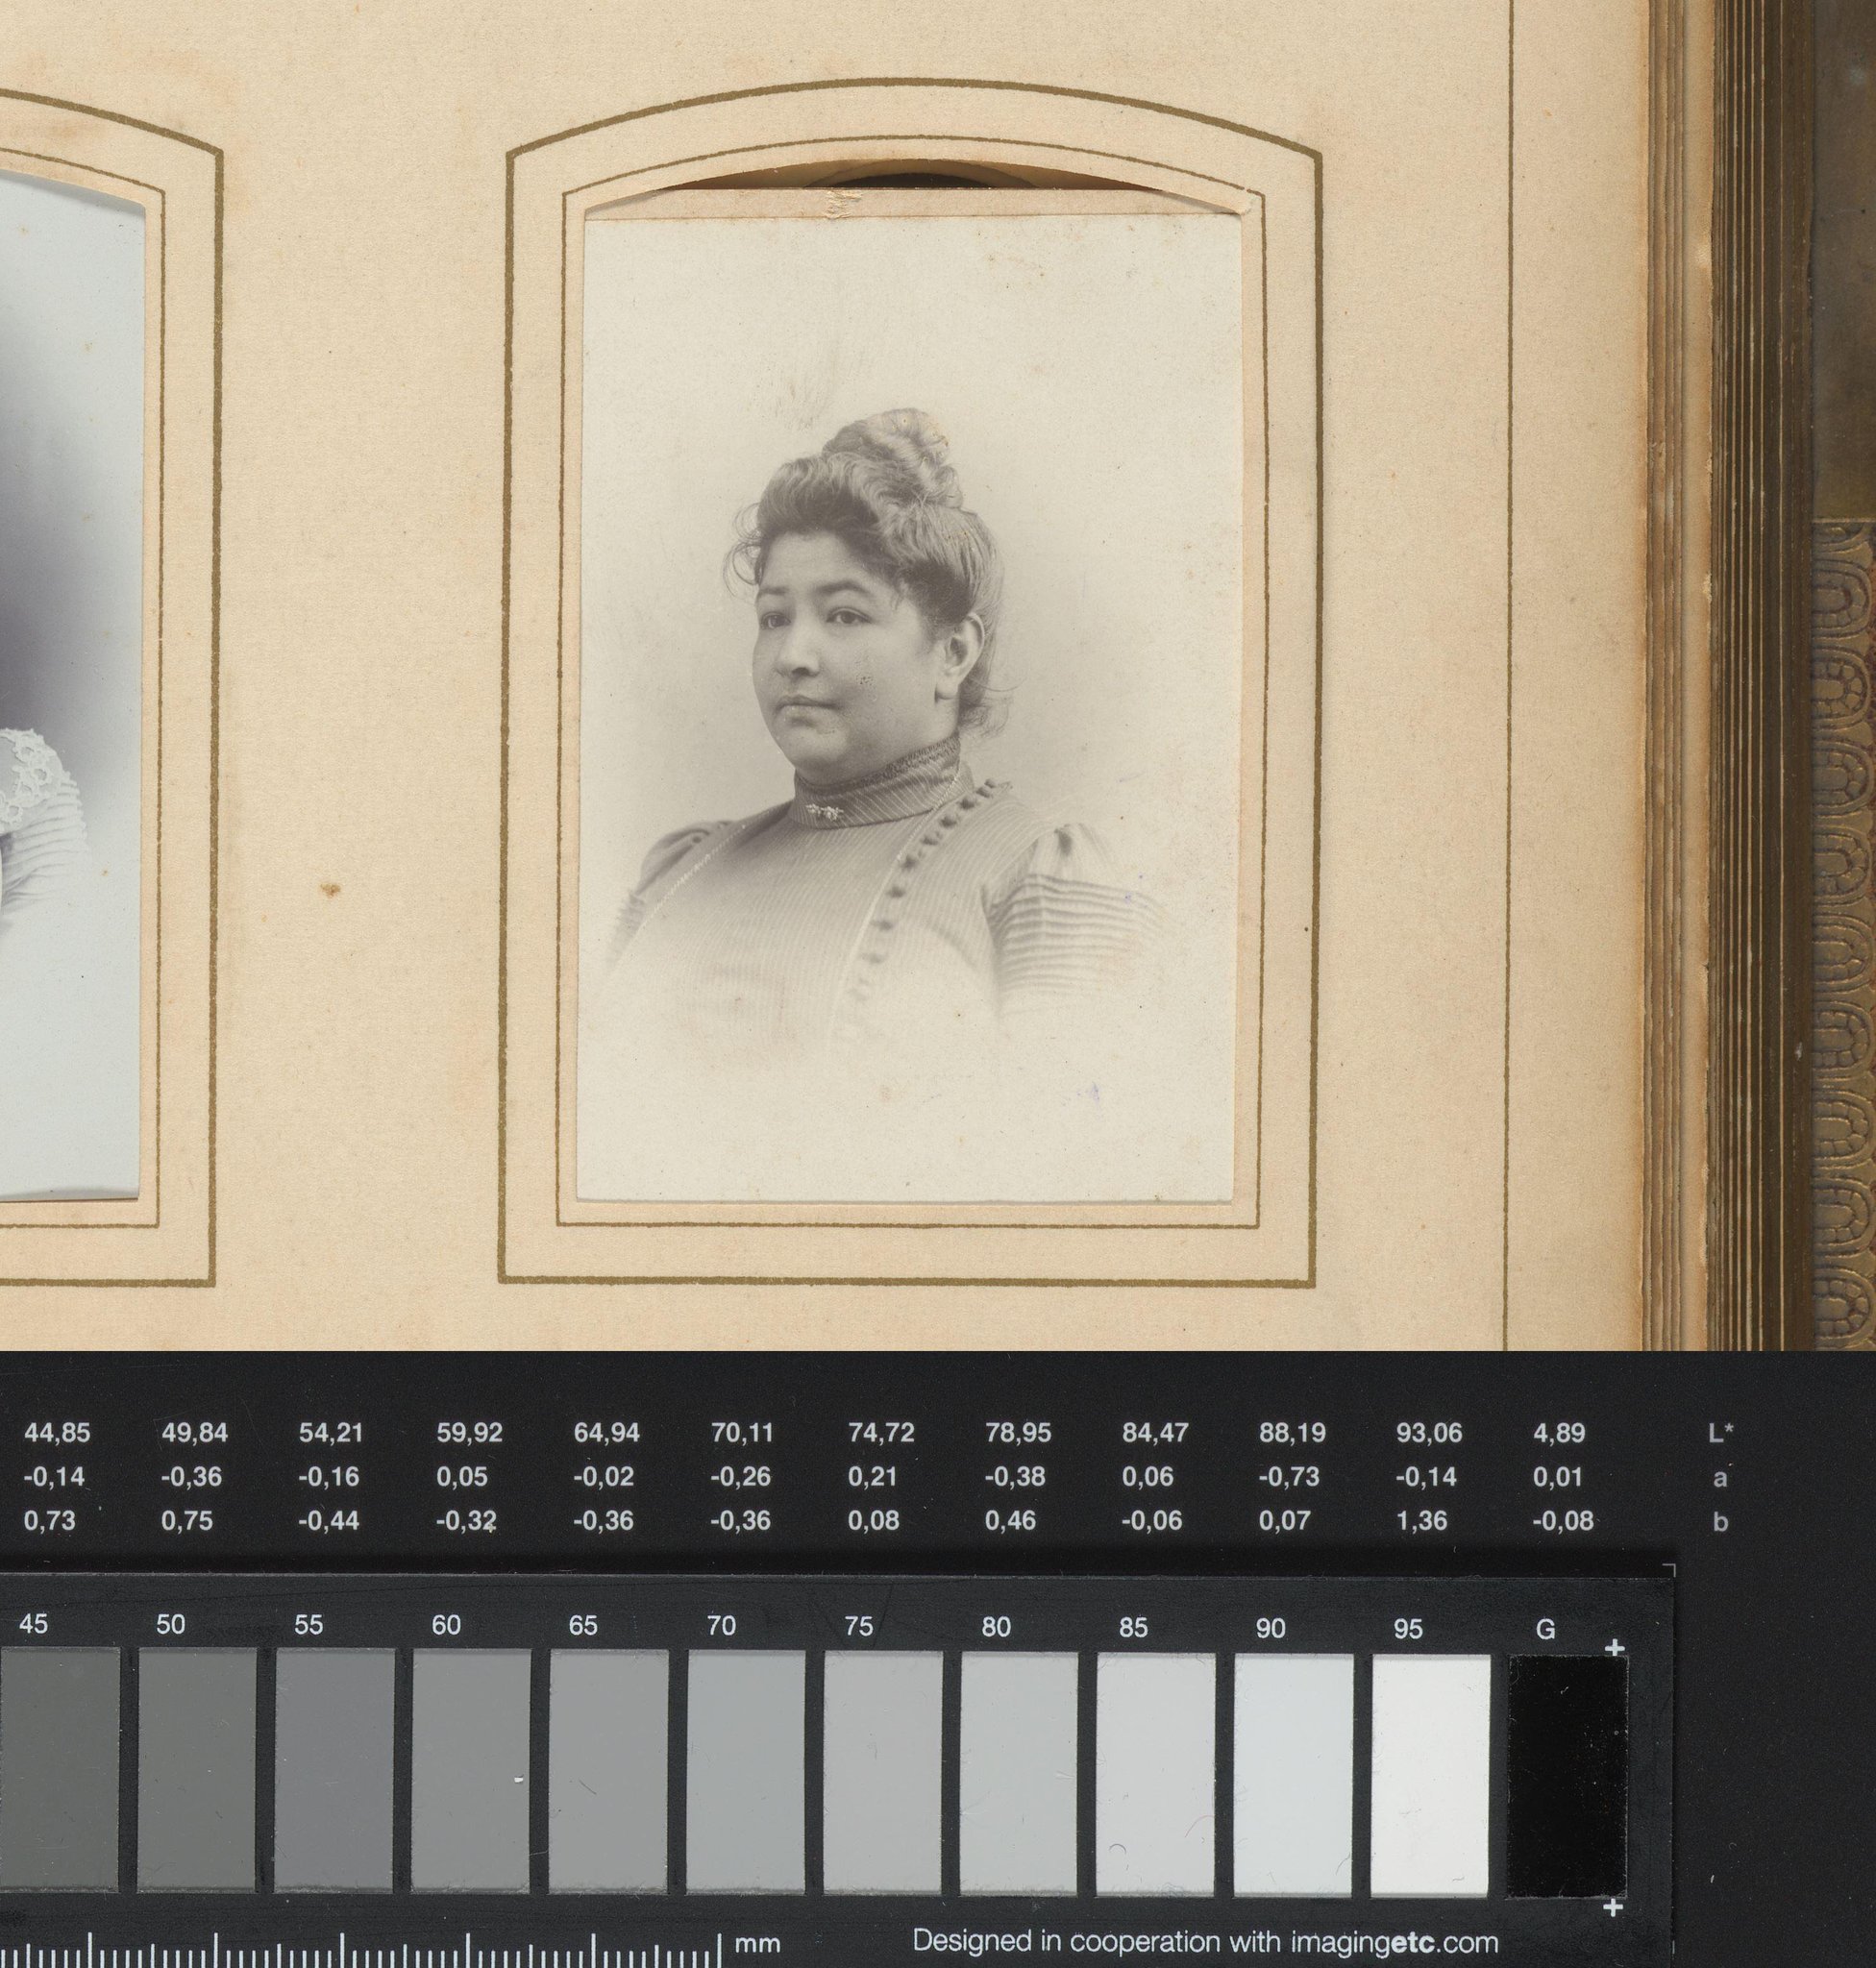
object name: carte de visite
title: Portret van een vrouw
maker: adolphe zimmermans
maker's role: fotograaf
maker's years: 1858-1922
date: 1884-1913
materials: cardboard, photographic support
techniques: matte daylight collodion silver print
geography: the hague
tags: historical persons - bb - woman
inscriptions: inscription: ‘Adolphe/ Zimmermans/ Photographe/ de/ S. M. la Reine/ La Haye/ de Riemerstraat 21.’